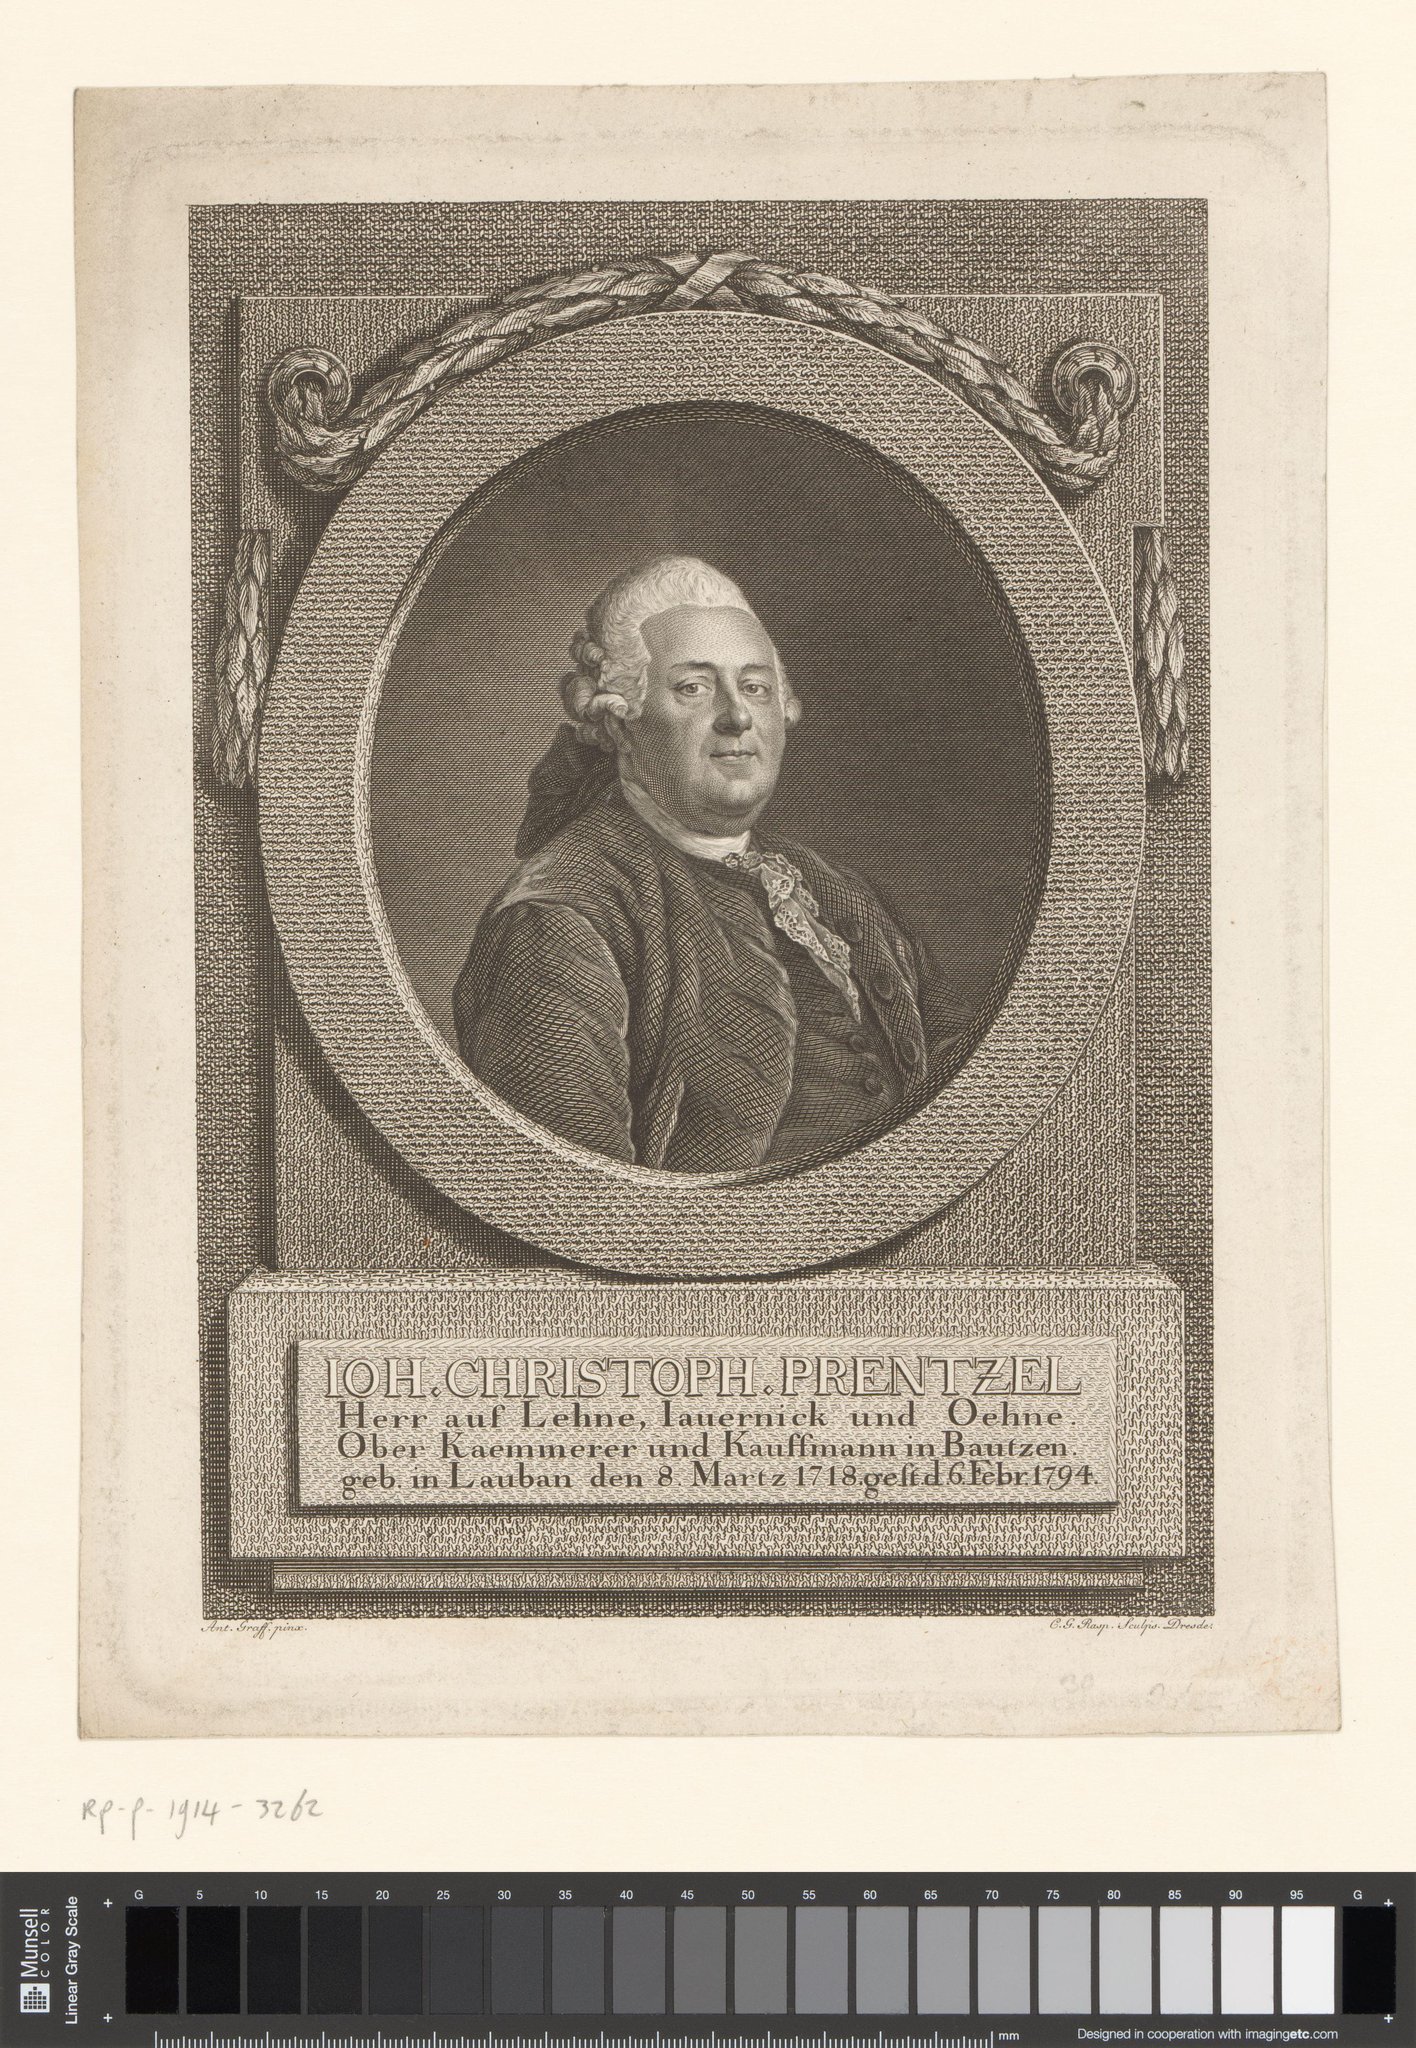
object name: print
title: Portret van Johann Christoph Prentzel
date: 1794-1807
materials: paper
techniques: engraving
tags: historical persons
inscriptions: collector's mark: Lugt 2228